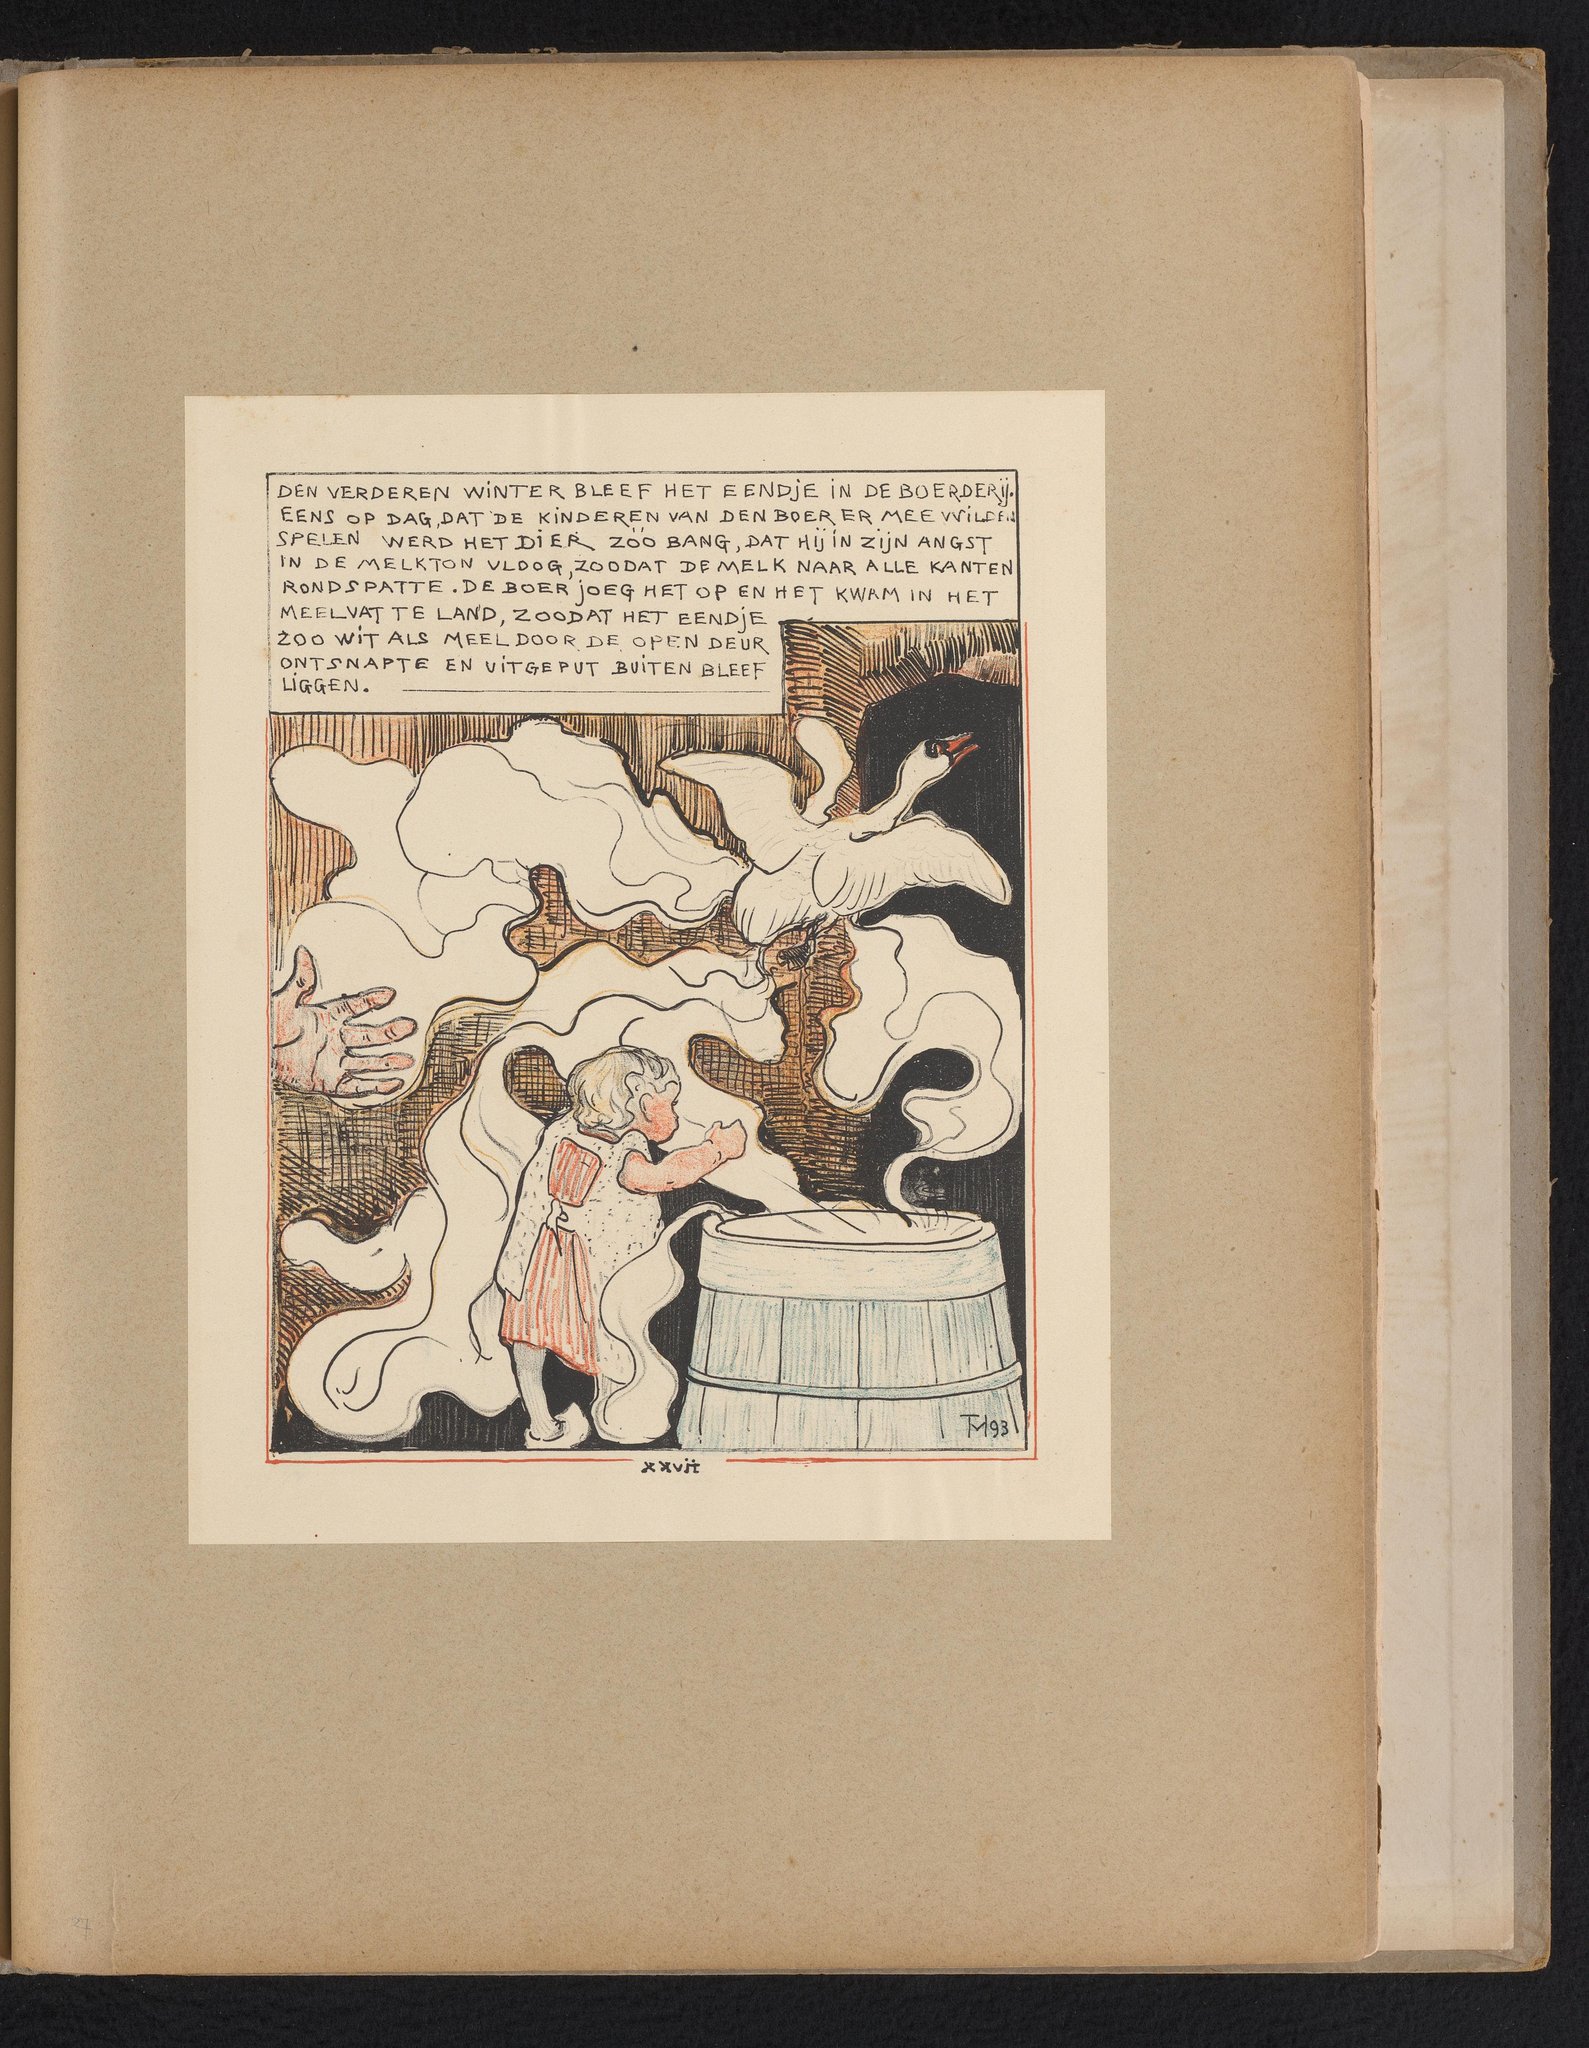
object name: album leaf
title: Opgejaagde zwaan vliegt in de melkton en het meelvat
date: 1893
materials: paper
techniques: lithograph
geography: the hague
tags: water-birds: swan, toddler - aa - girl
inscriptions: date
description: Deze prent maakt deel uit van een album.